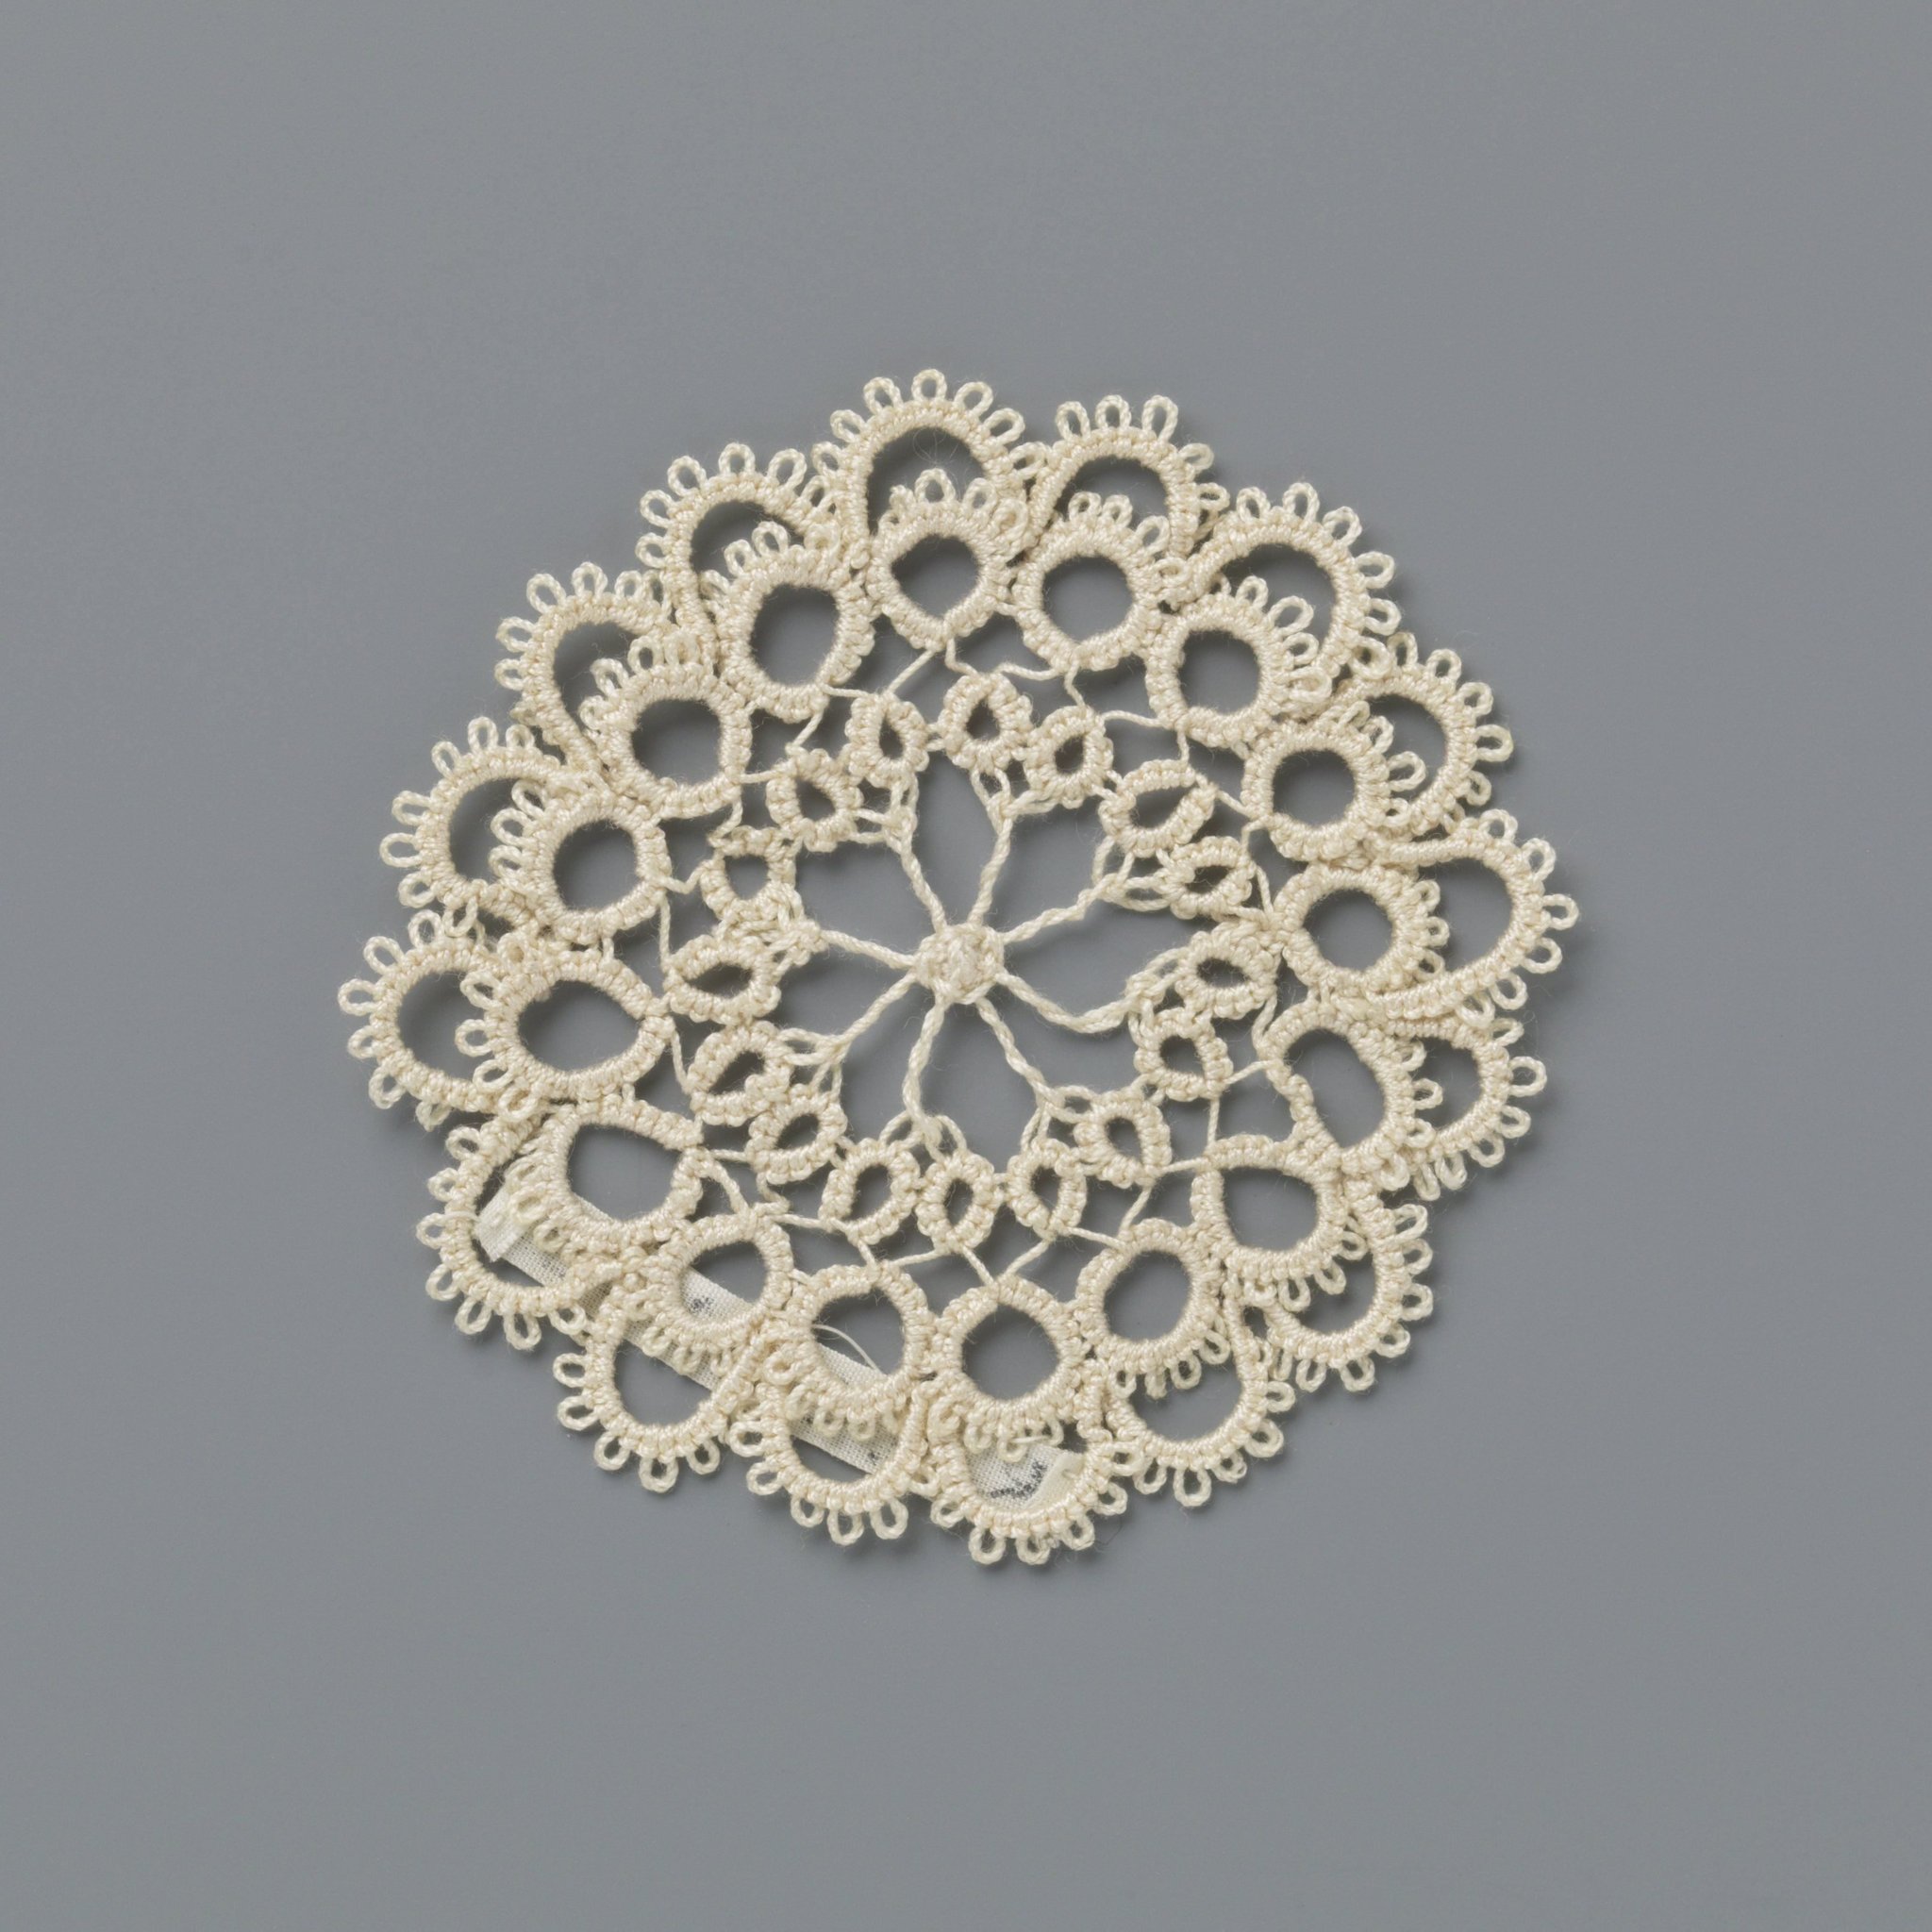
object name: strip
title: Strook geknoopte kant met twee rijen lussen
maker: marie waldeck-reiss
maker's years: 1870-1942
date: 1900-1939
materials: linen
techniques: tatting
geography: amsterdam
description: Strook naturelkleurige geknoopte kant: frivolité. Twee rijen lusjes. Aan de boven- en onderzijde zit aan elk lusje een picot.